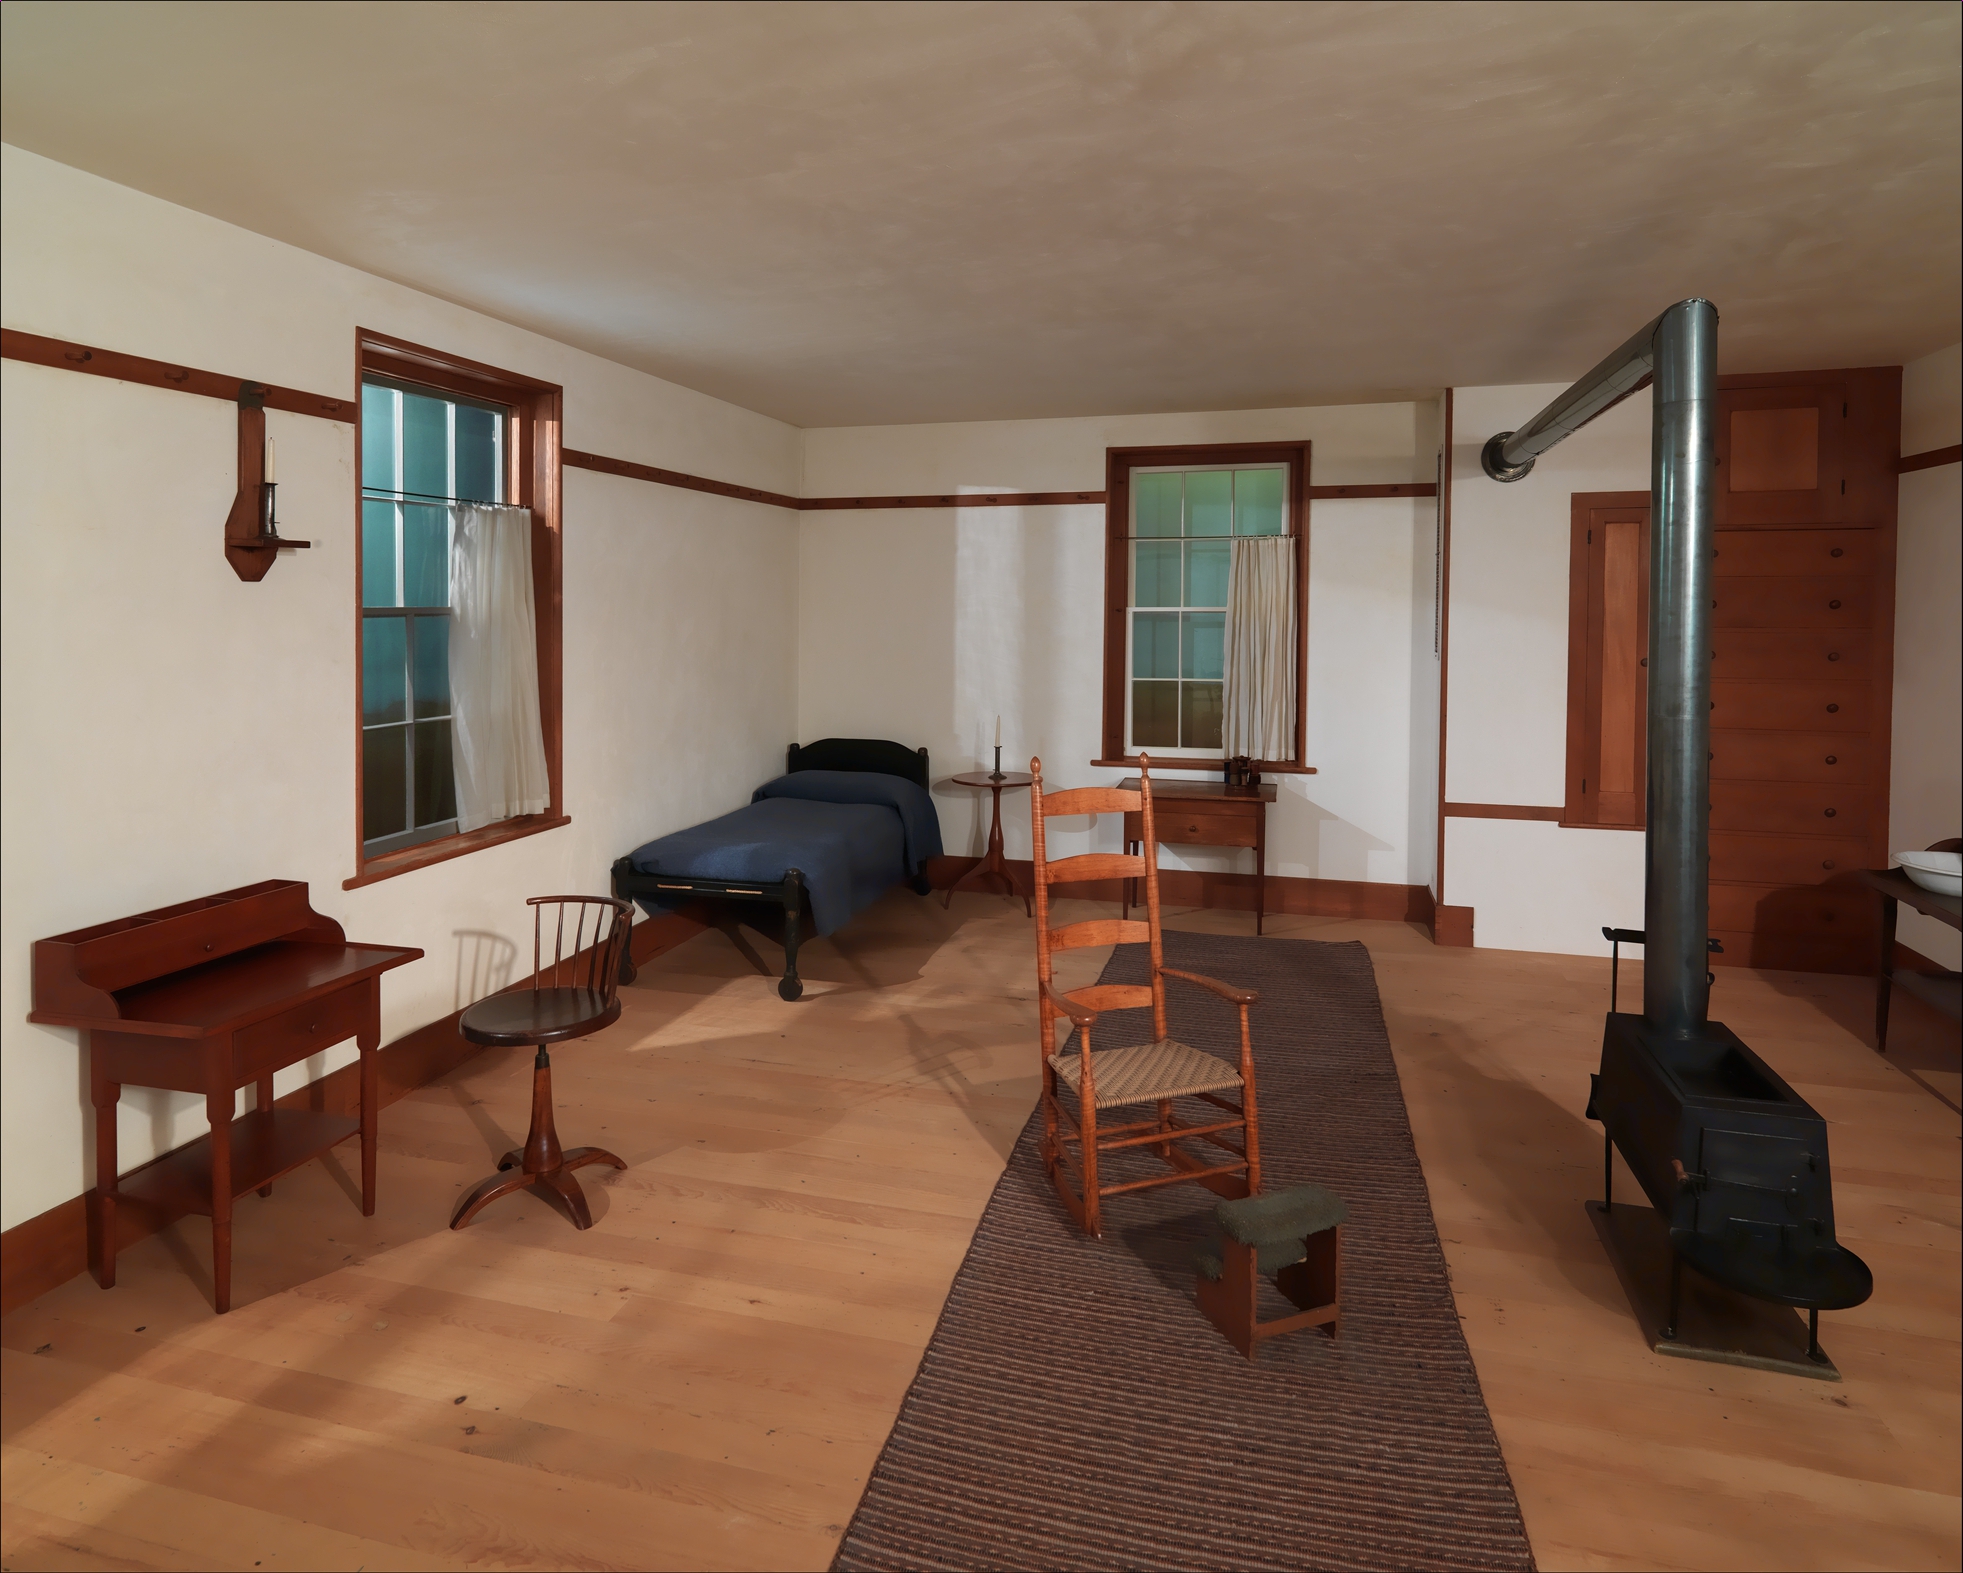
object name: bedroom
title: Architectural elements from a Retiring Room in the North Family Dwelling American, New Lebanon, New York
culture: american, shaker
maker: united society of believers in christ’s second appearing (“shakers”)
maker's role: maker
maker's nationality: american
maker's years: 1750-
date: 1830-1840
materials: wood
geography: united states